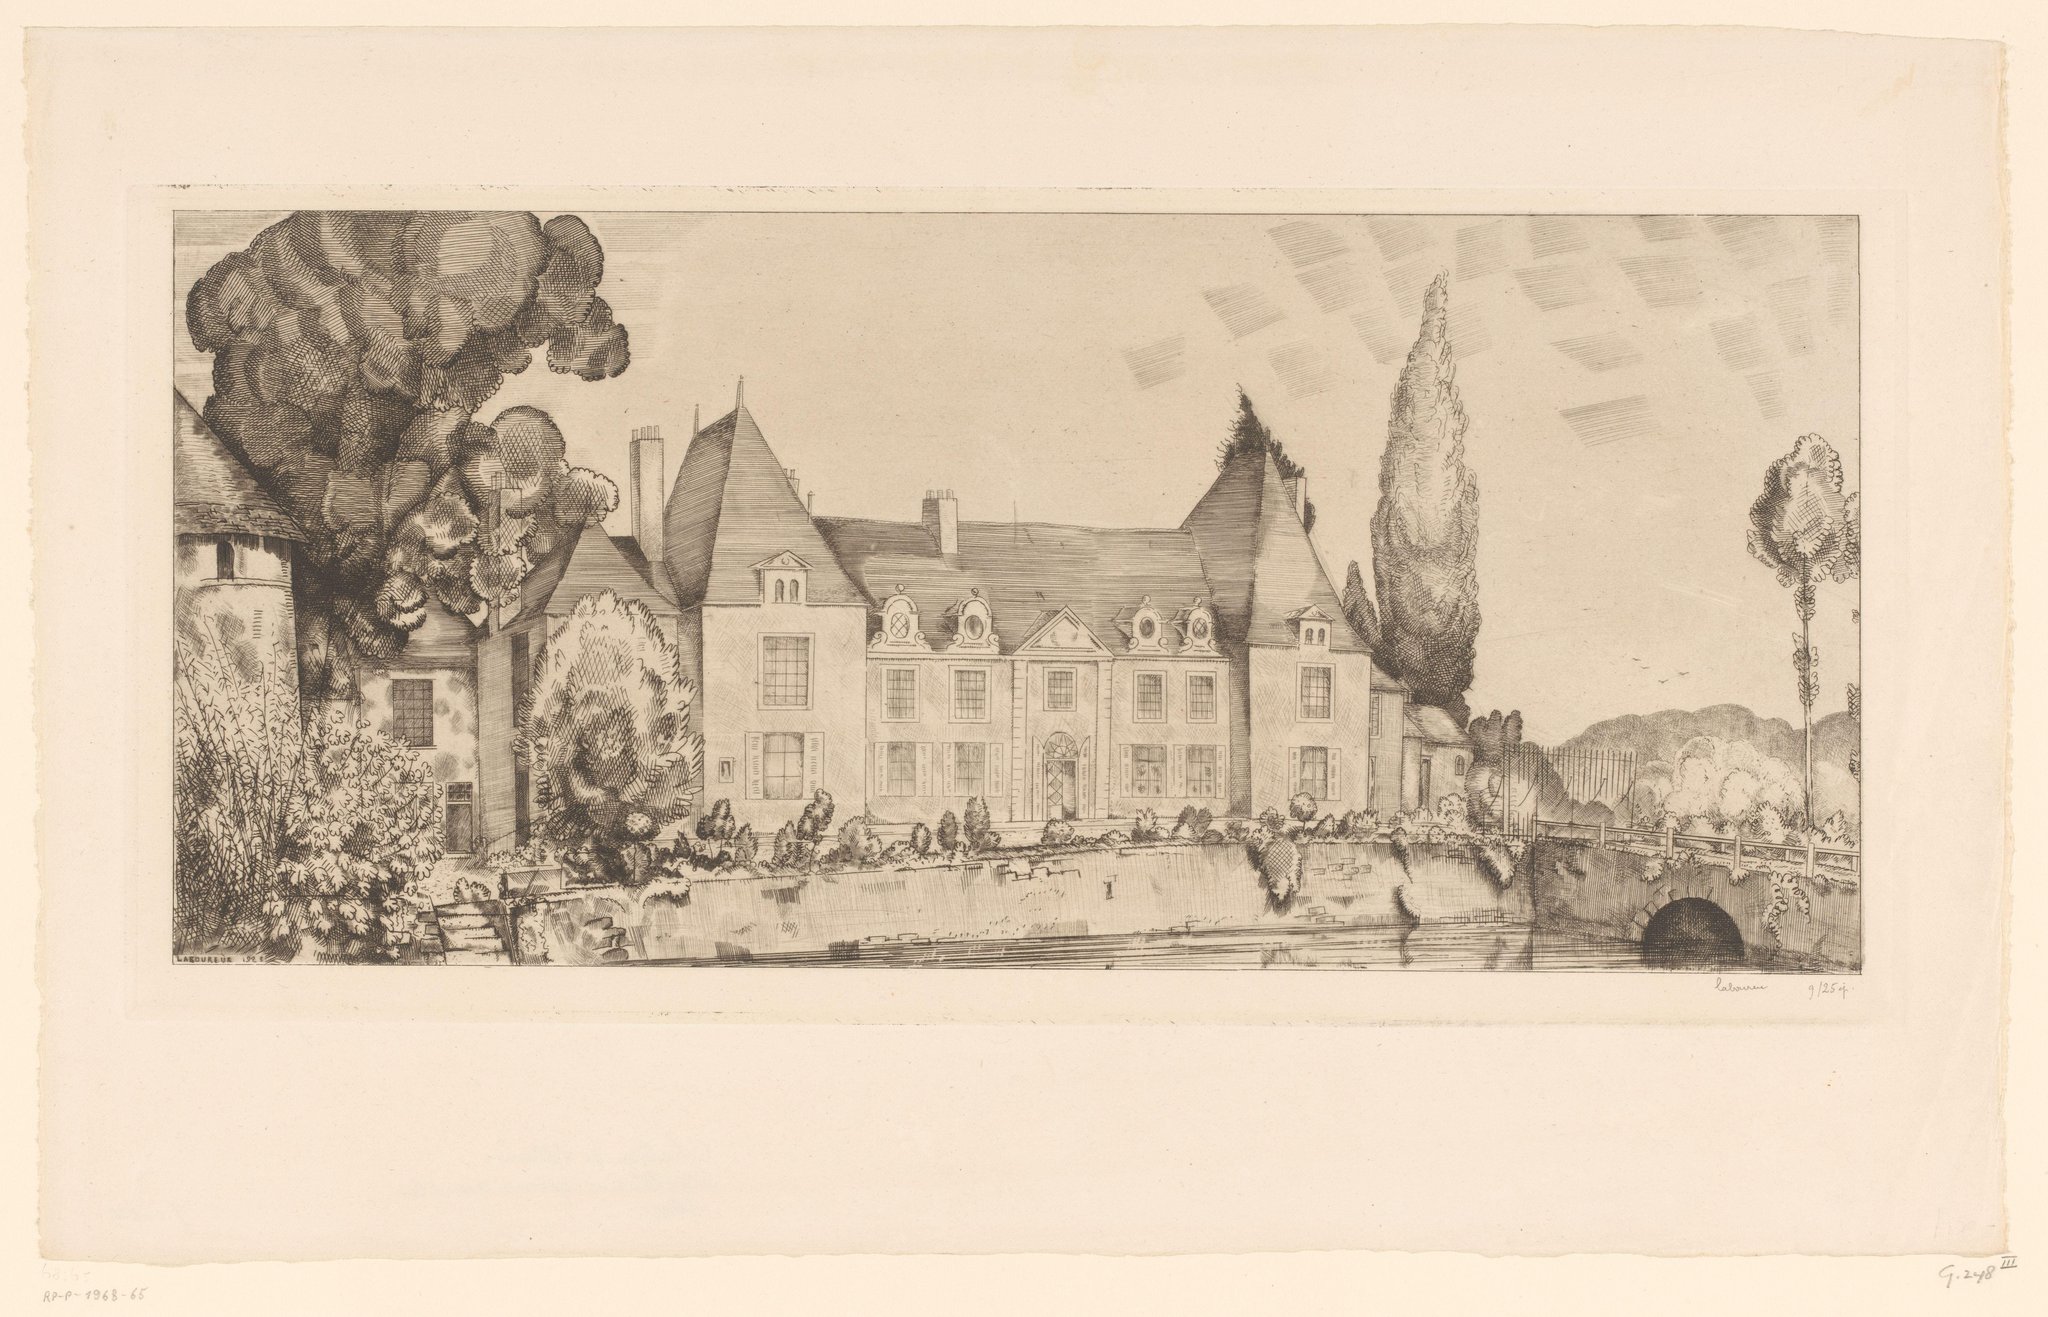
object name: print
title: Zicht op een kasteel aan het water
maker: jean emile laboureur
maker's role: draughtsman, print maker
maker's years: 1877-1943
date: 1923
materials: paper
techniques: drypoint, engraving, etching, intaglio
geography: france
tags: castle, water course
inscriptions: collector's mark: Lugt 2760, collector's mark: Lugt 2228